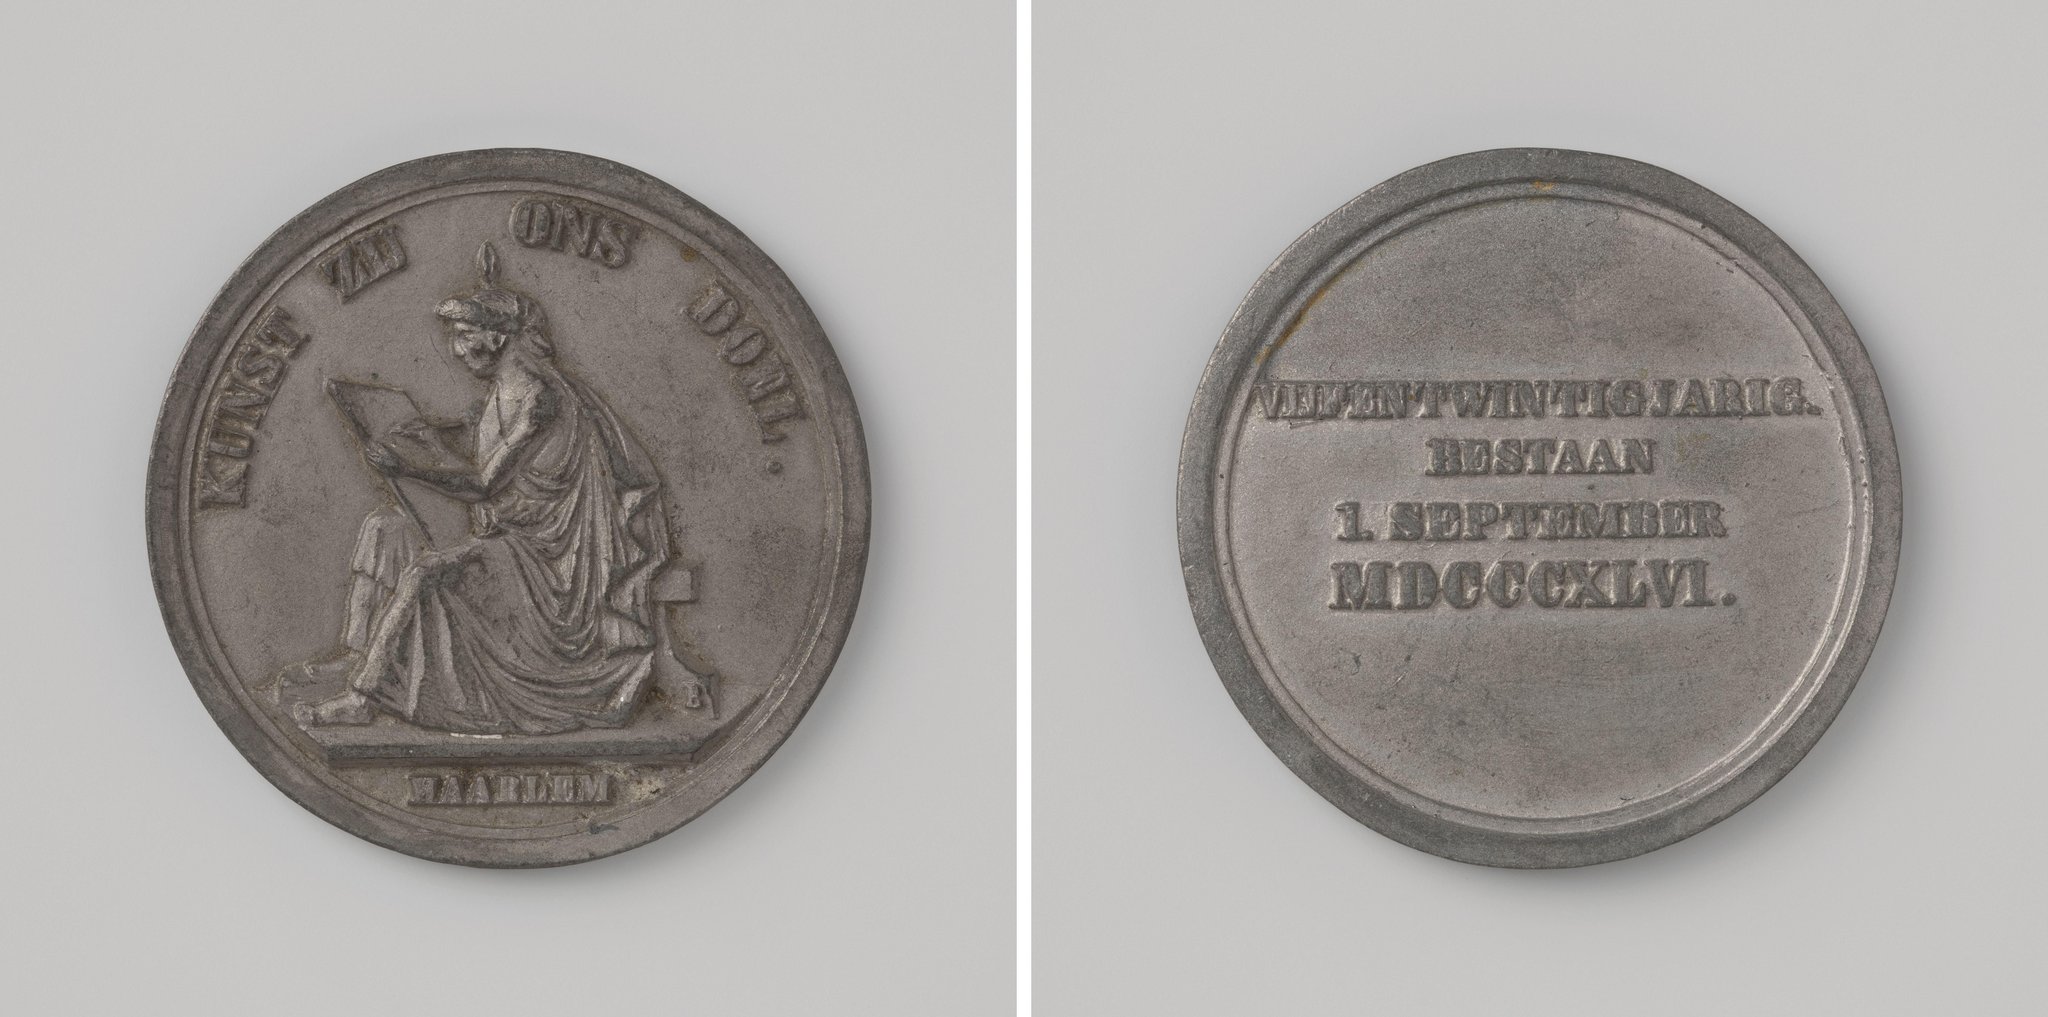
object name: history medal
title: Vijfentwintigjarig bestaan van Kunst Zij Ons Doel te Haarlem 1846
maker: bemme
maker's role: medailleur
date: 1846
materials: tin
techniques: casting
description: Penning van letterspecie, op de voorzijde de Tekenkunst als zittende vrouw met lei en griffel, met omschrift en afsnedetekst, op de keerzijde vier regels tekst.